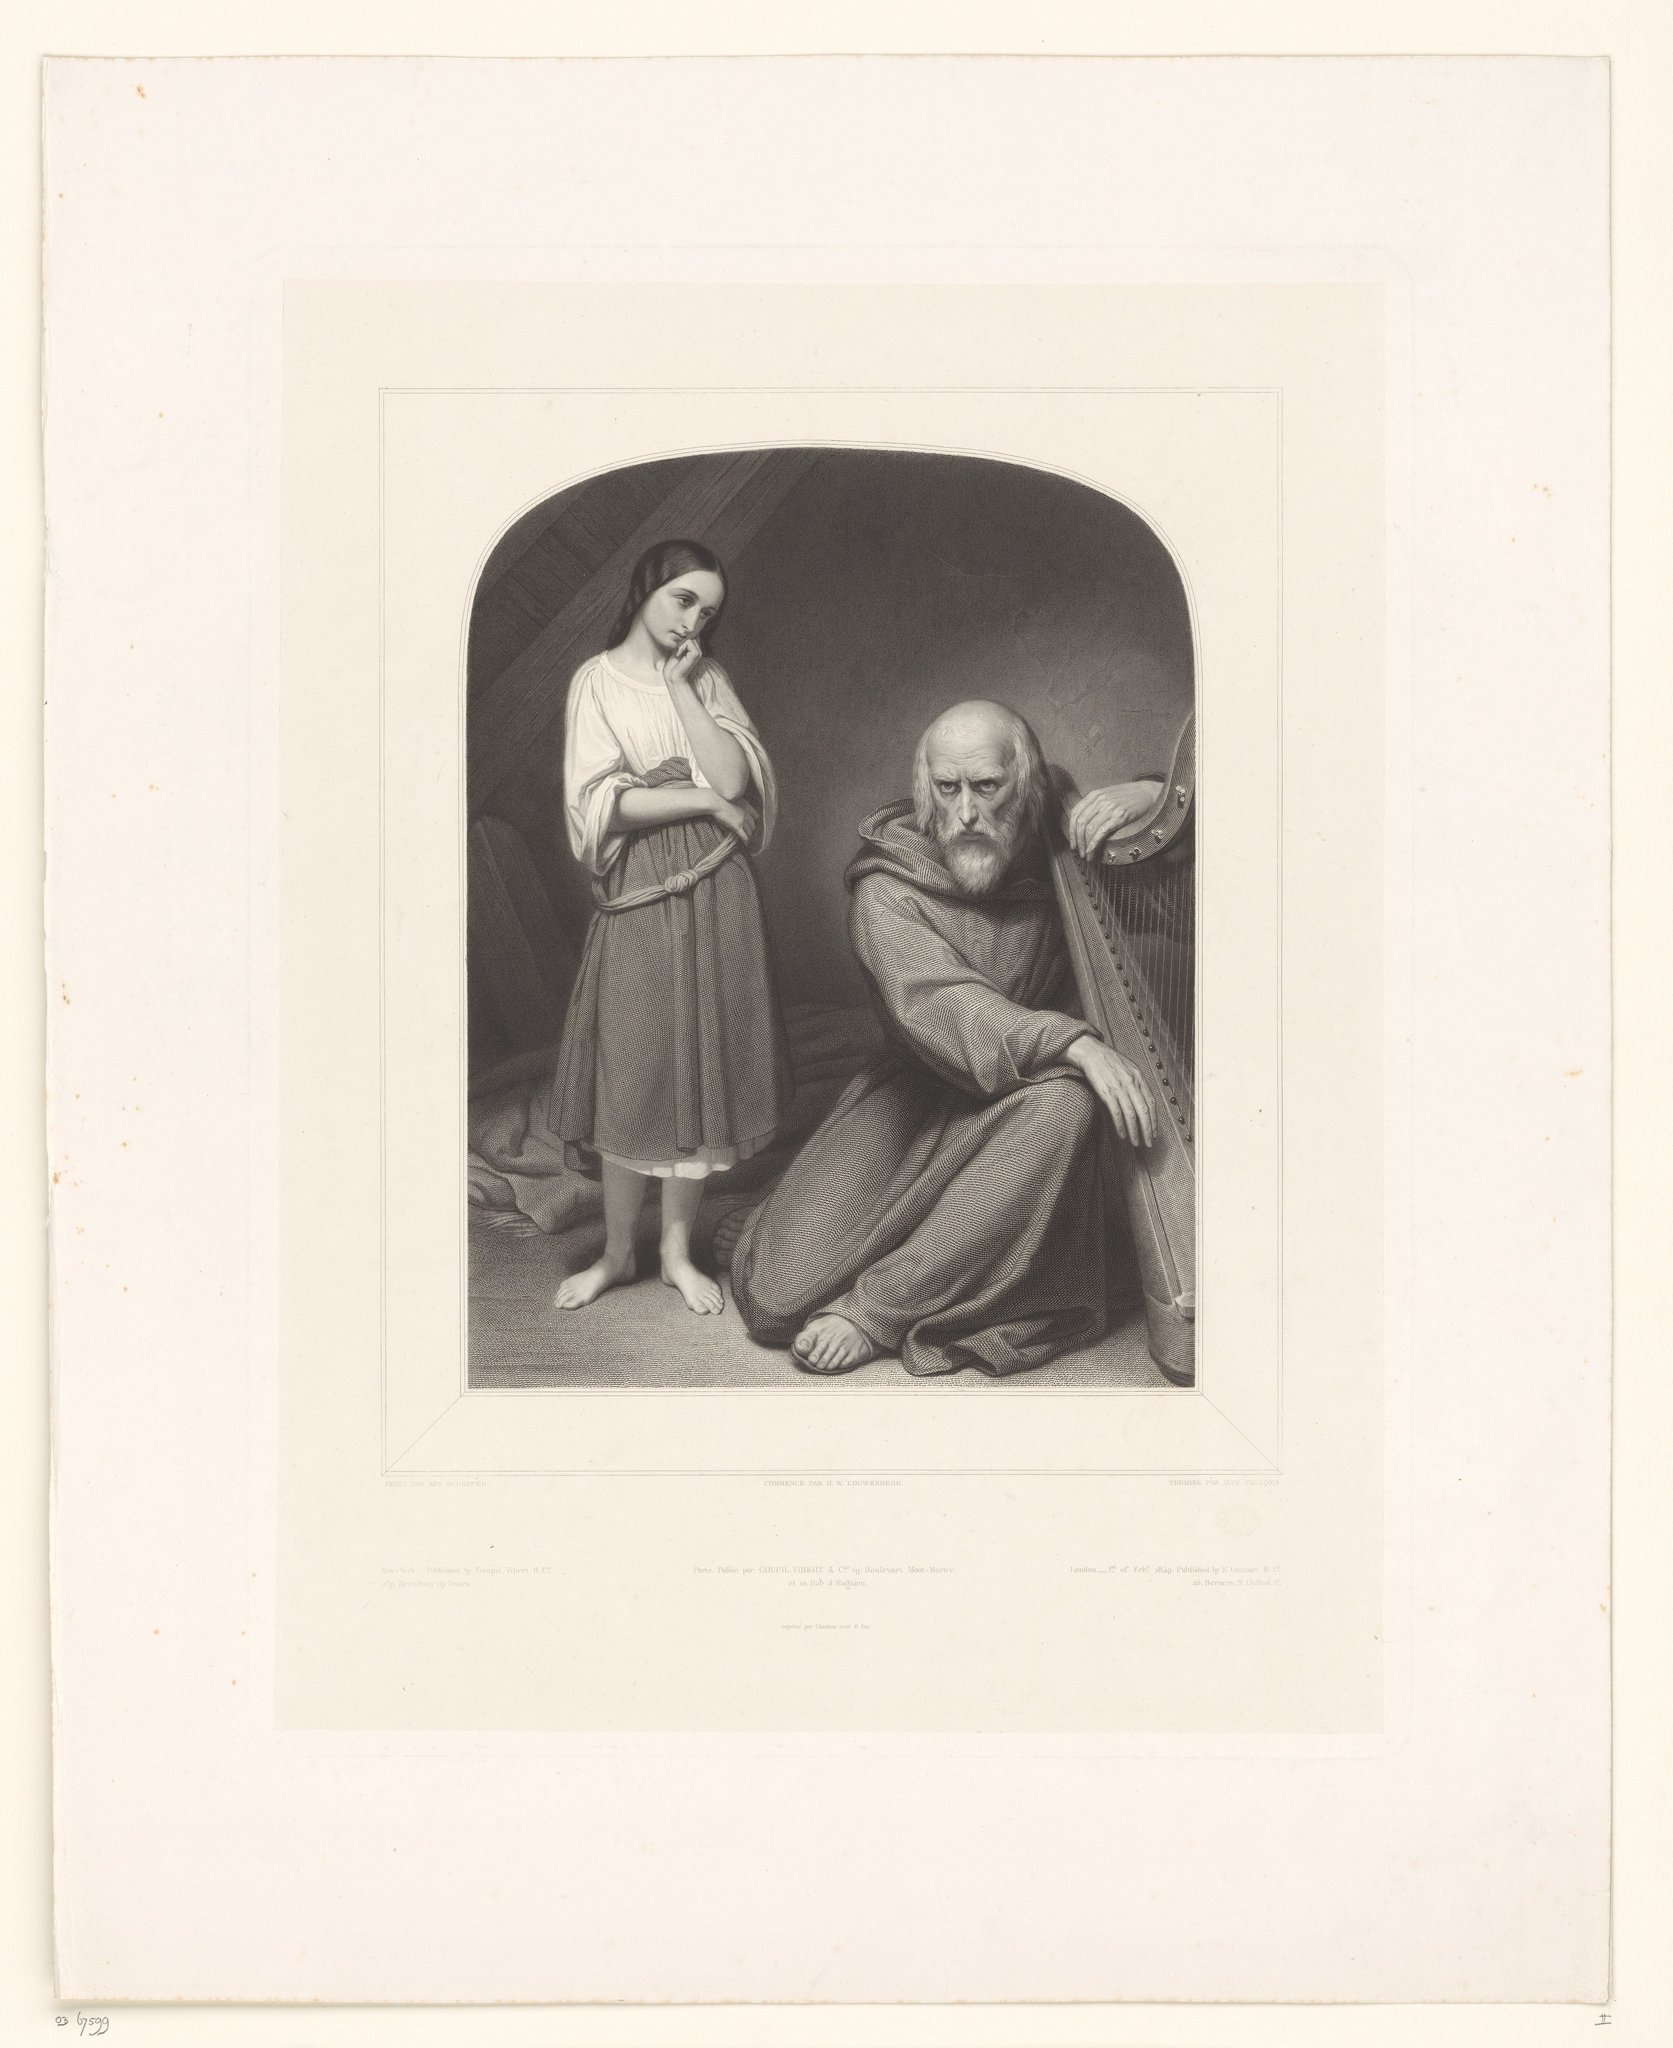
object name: print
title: Meisje met oude monnik met harp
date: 1849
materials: paper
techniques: engraving, etching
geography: paris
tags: monk(s), friar(s), girl (child between toddler and youth), harp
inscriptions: check stamp: ‘Printsellers Association NUK’, collector's mark: Lugt 12